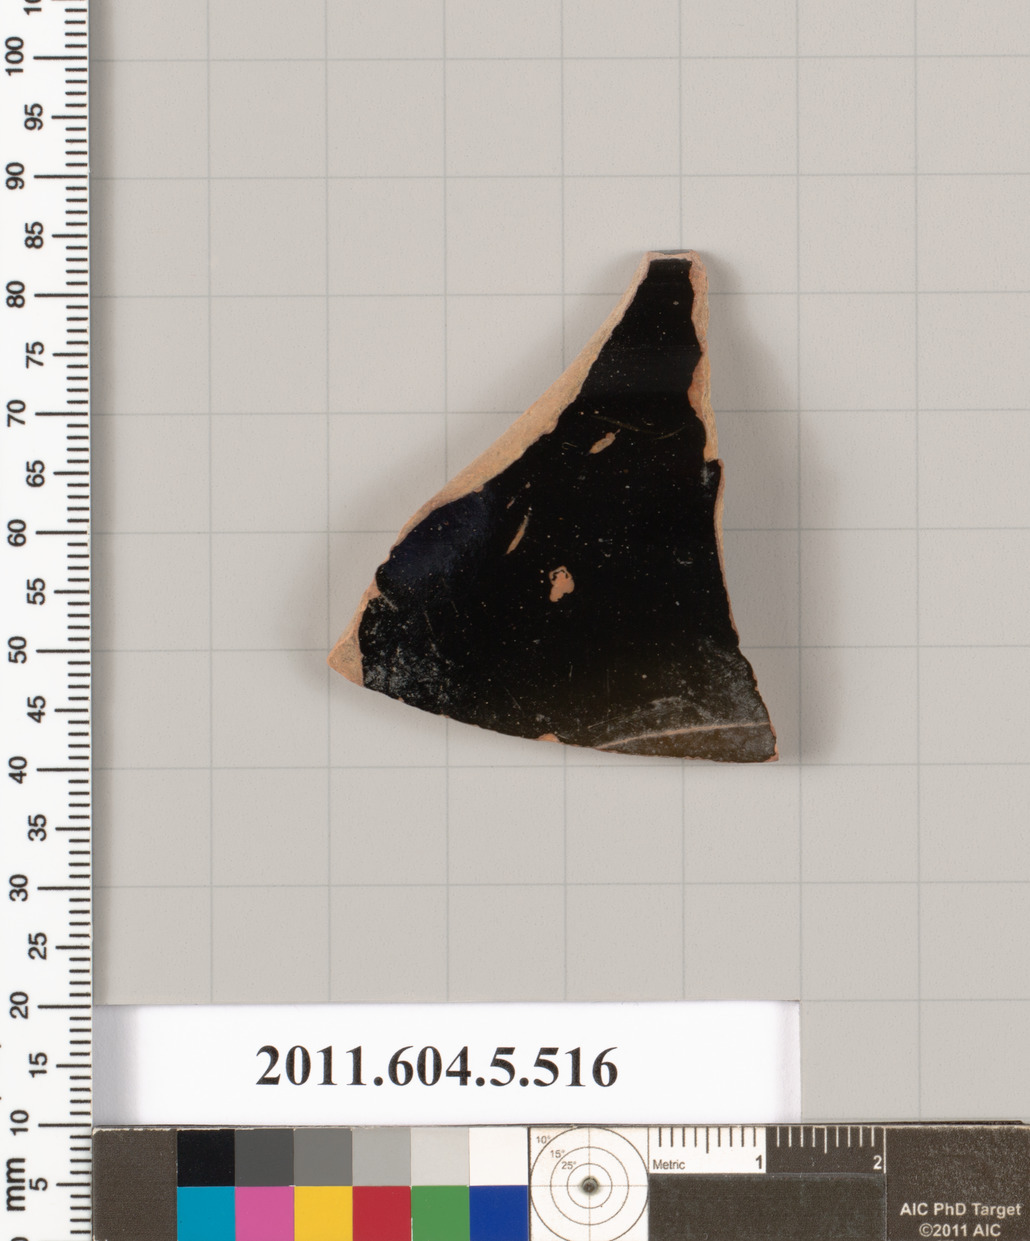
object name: kylix fragment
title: Terracotta rim fragment of a kylix (drinking cup)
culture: greek, attic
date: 600-401 BCE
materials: terracotta